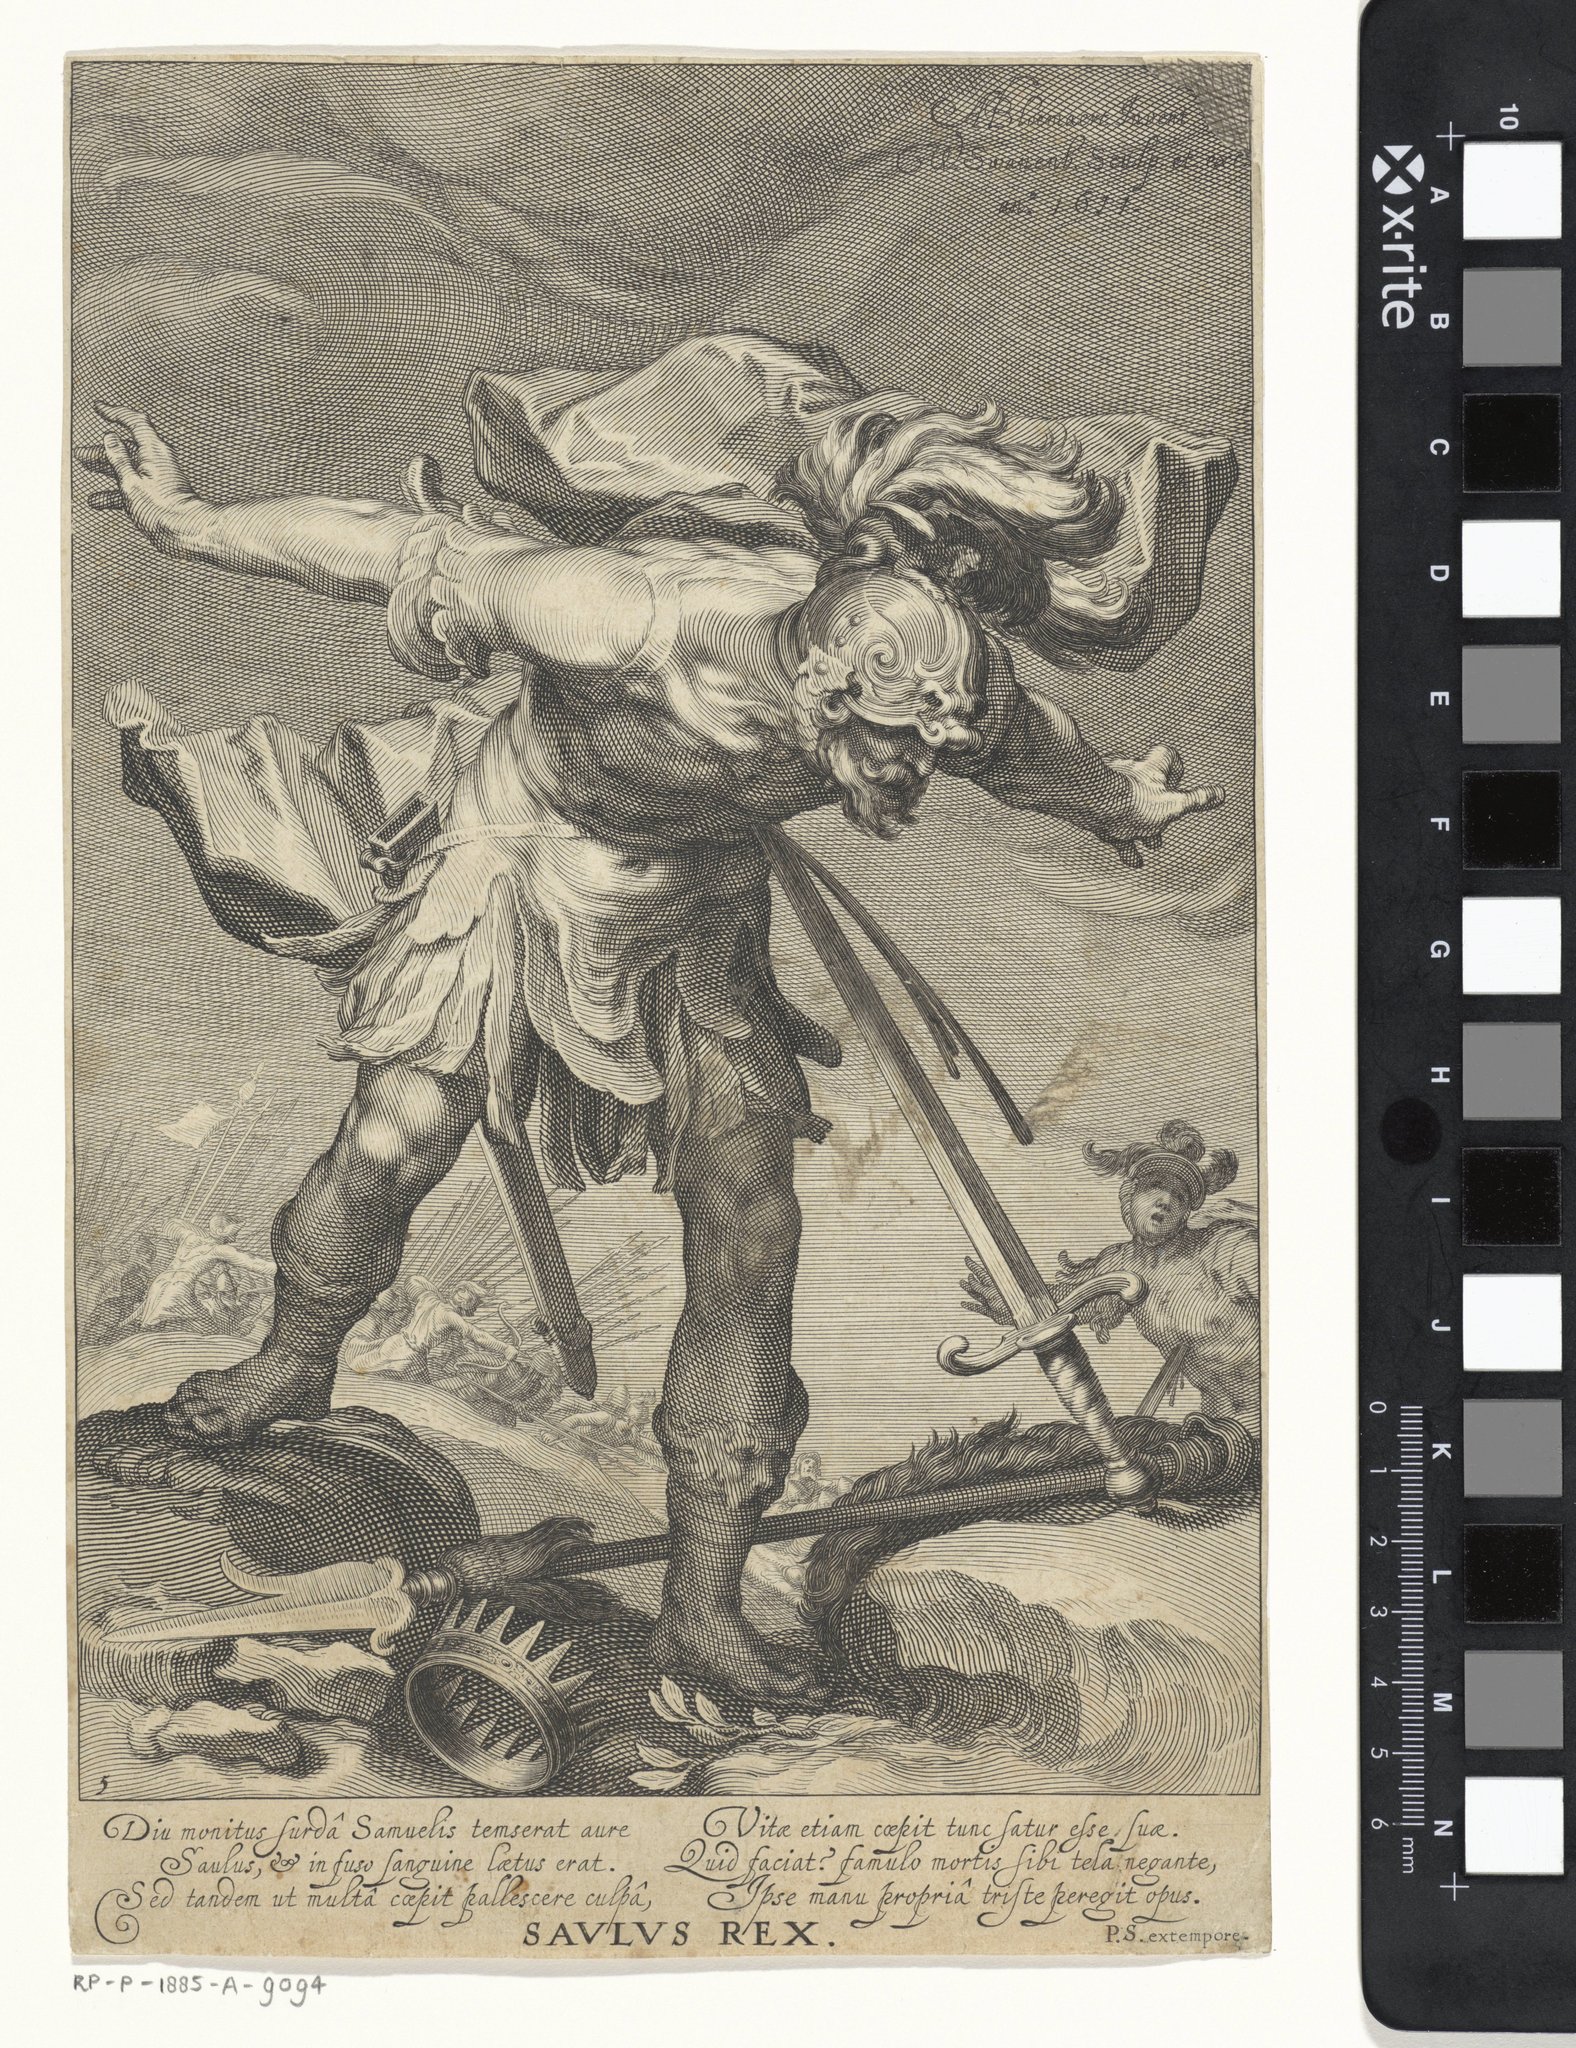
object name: print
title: Koning Saul stort zich in zijn zwaard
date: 1611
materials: paper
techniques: engraving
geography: utrecht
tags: saul kills himself with a sword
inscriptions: collector's mark: Lugt 2228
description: Op het slagveld doodt koning Saul zichzelf door zich in zijn eigen zwaard te storten. Hij draagt een wapenrusting en voor hem ligt een kroon en een lans. Rechts achter hem kijkt een soldaat verschrikt toe. In de verte zijn vechtende soldaten te zien. Onder de voorstelling bevindt zich een zesregelige, Latijnse tekst met een beschrijving van de scène.